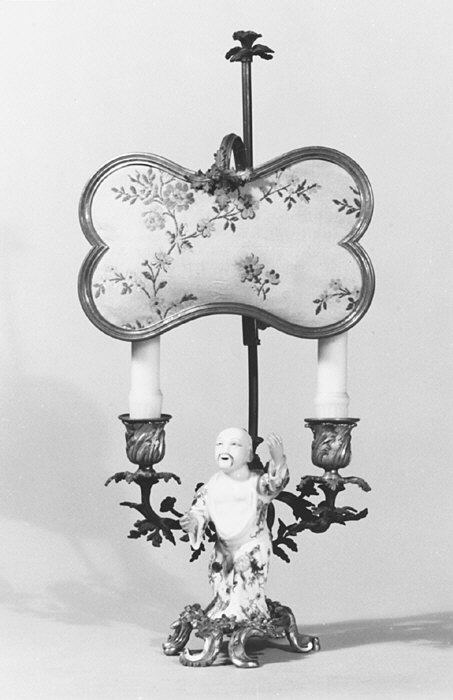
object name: figure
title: Figure of a Chinese man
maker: villeroy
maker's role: factory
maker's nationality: french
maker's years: 1734-1748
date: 1740-1745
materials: soft paste porcelain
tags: men,flowers,leaves